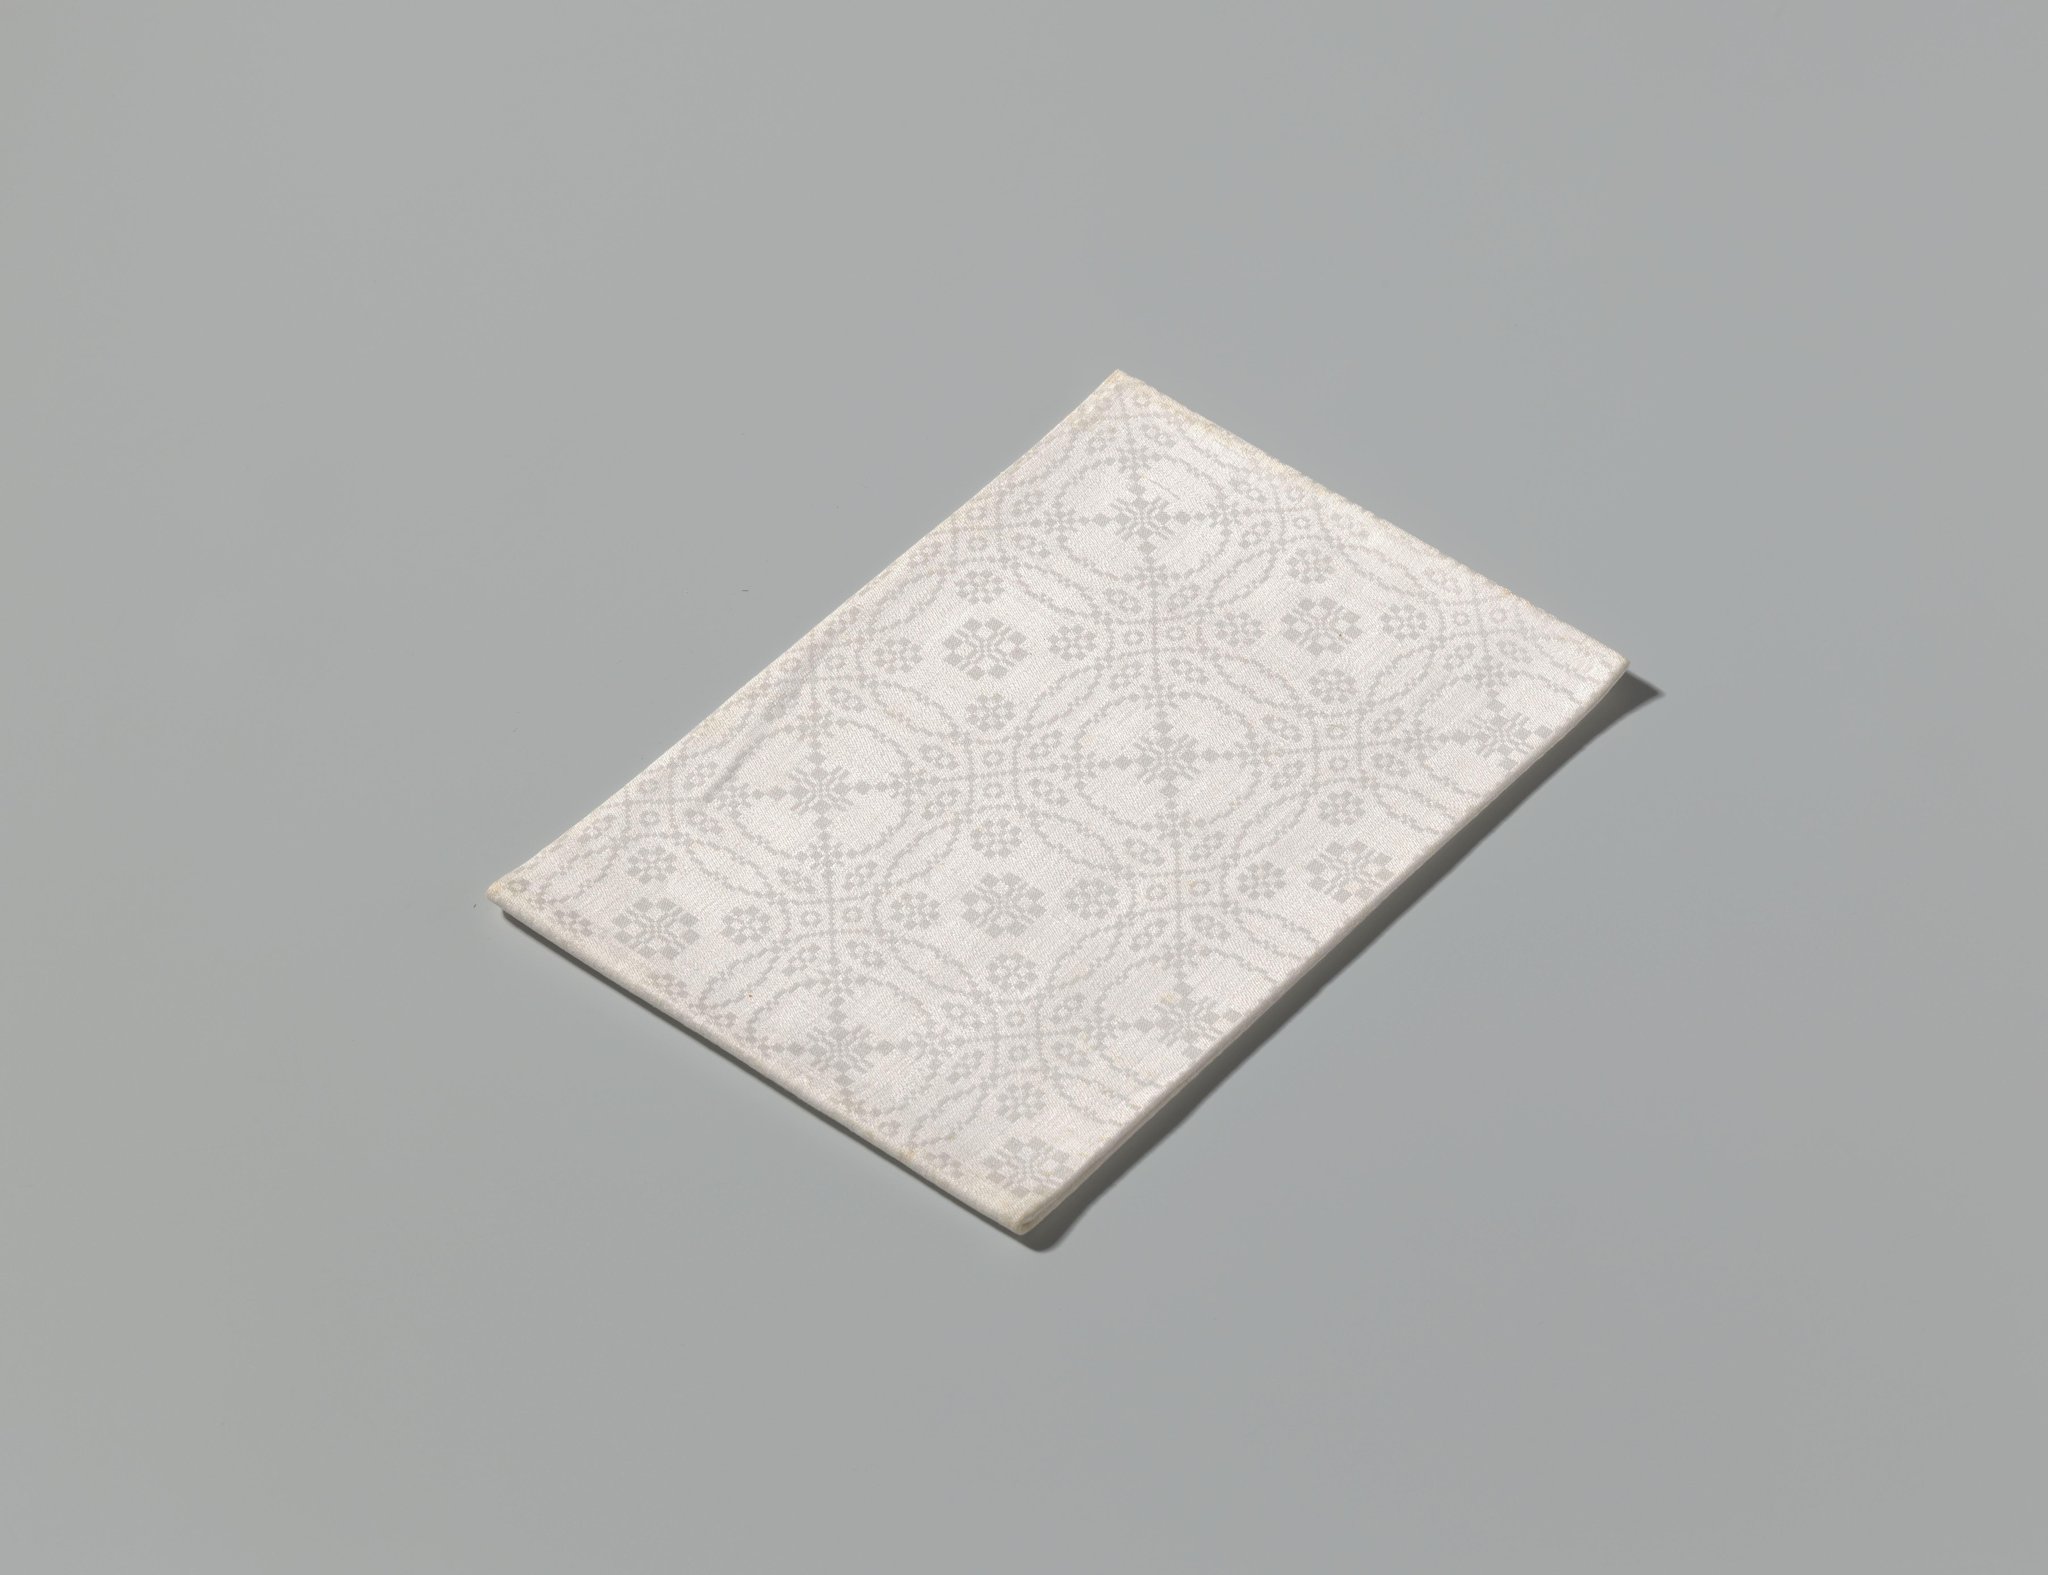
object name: napkin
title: Servet van linnen met pellenpatroon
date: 1660-1700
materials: linen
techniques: peeled fabric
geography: northern netherlands